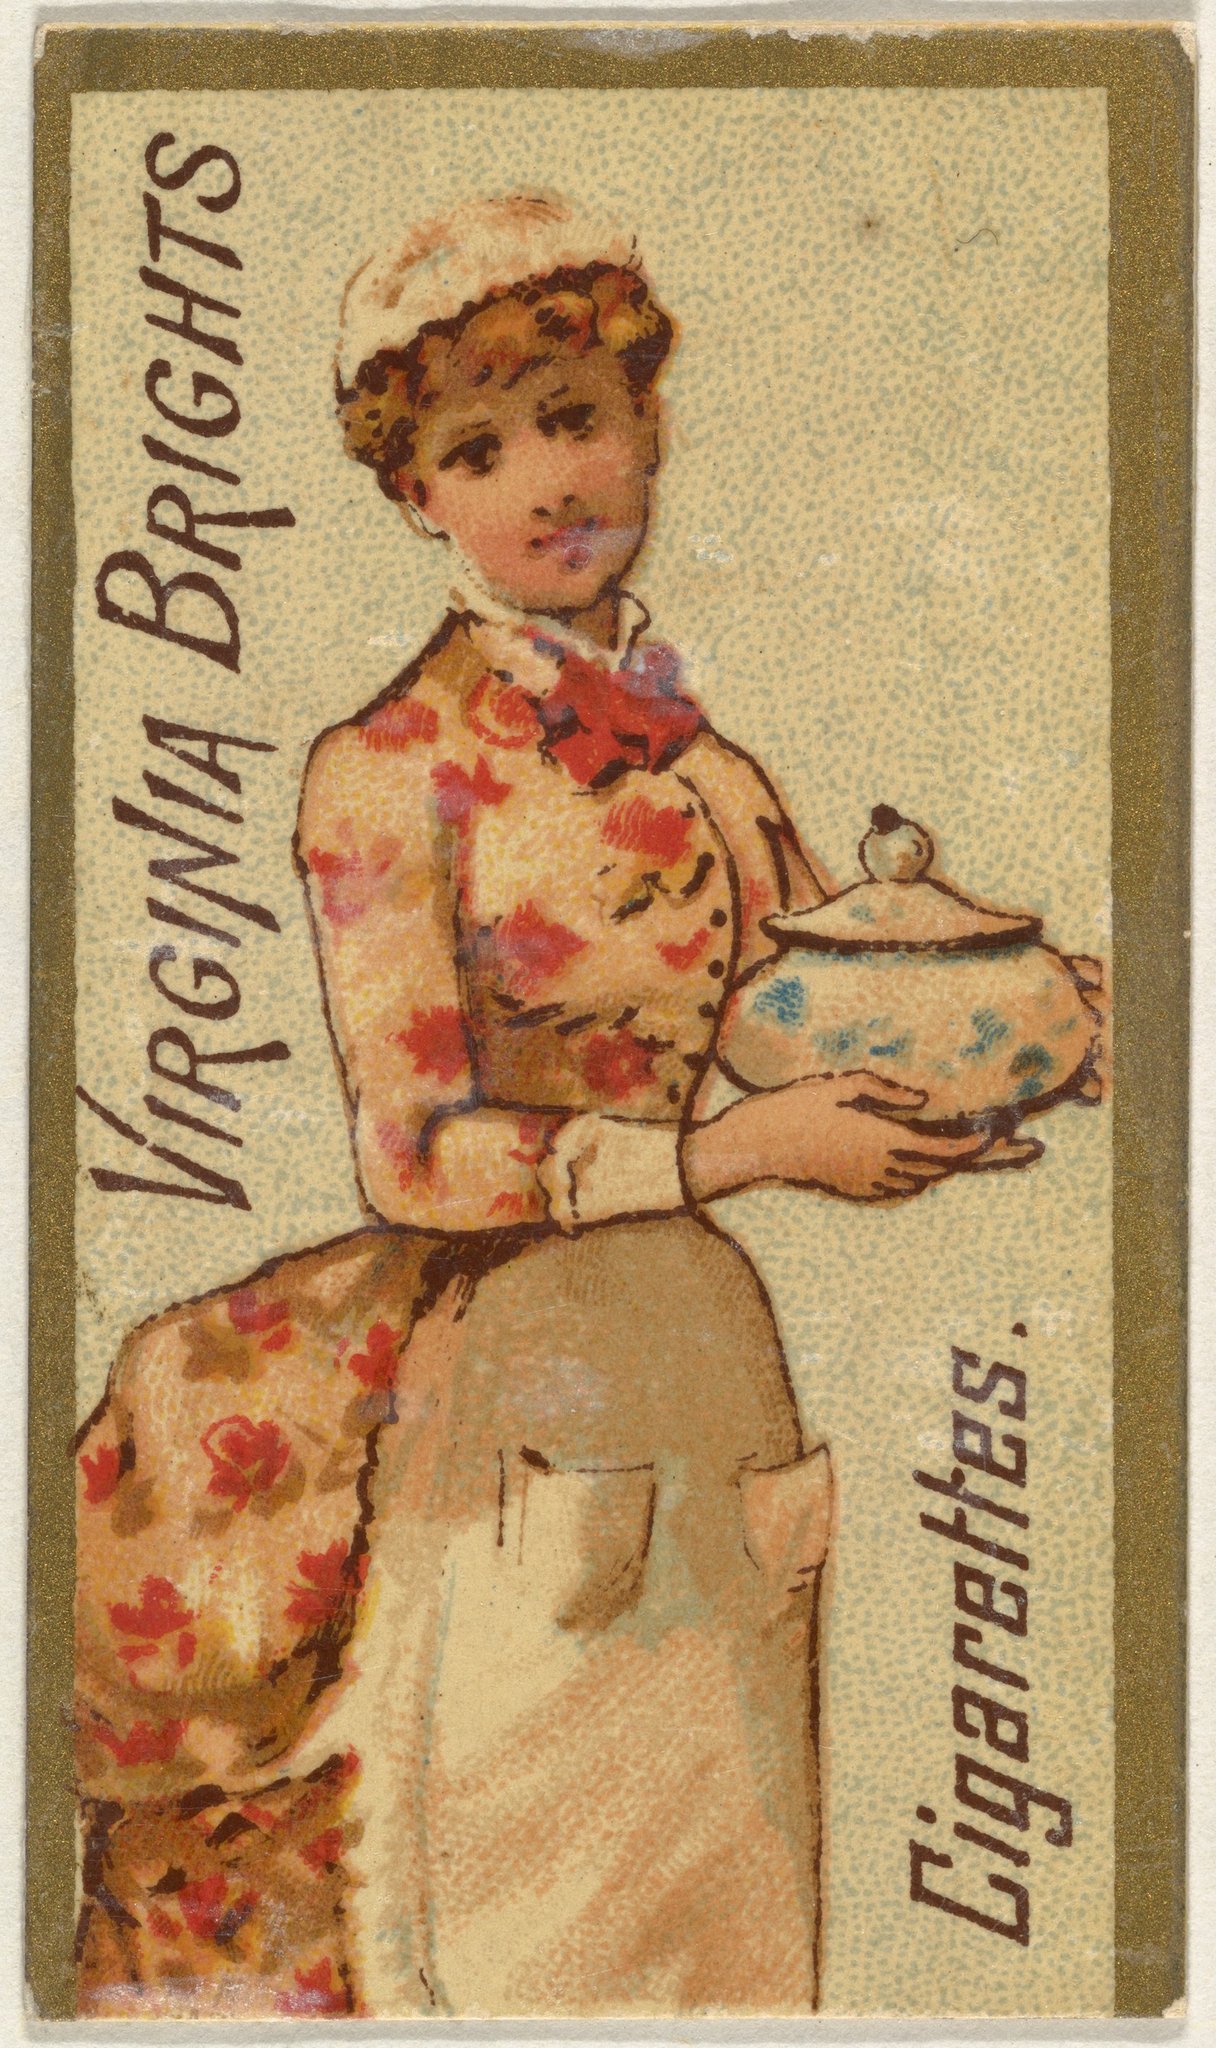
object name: print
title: From the Girls and Children series (N64) promoting Virginia Brights Cigarettes for Allen & Ginter brand tobacco products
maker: allen & ginter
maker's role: publisher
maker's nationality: american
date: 1886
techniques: color lithograph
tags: women